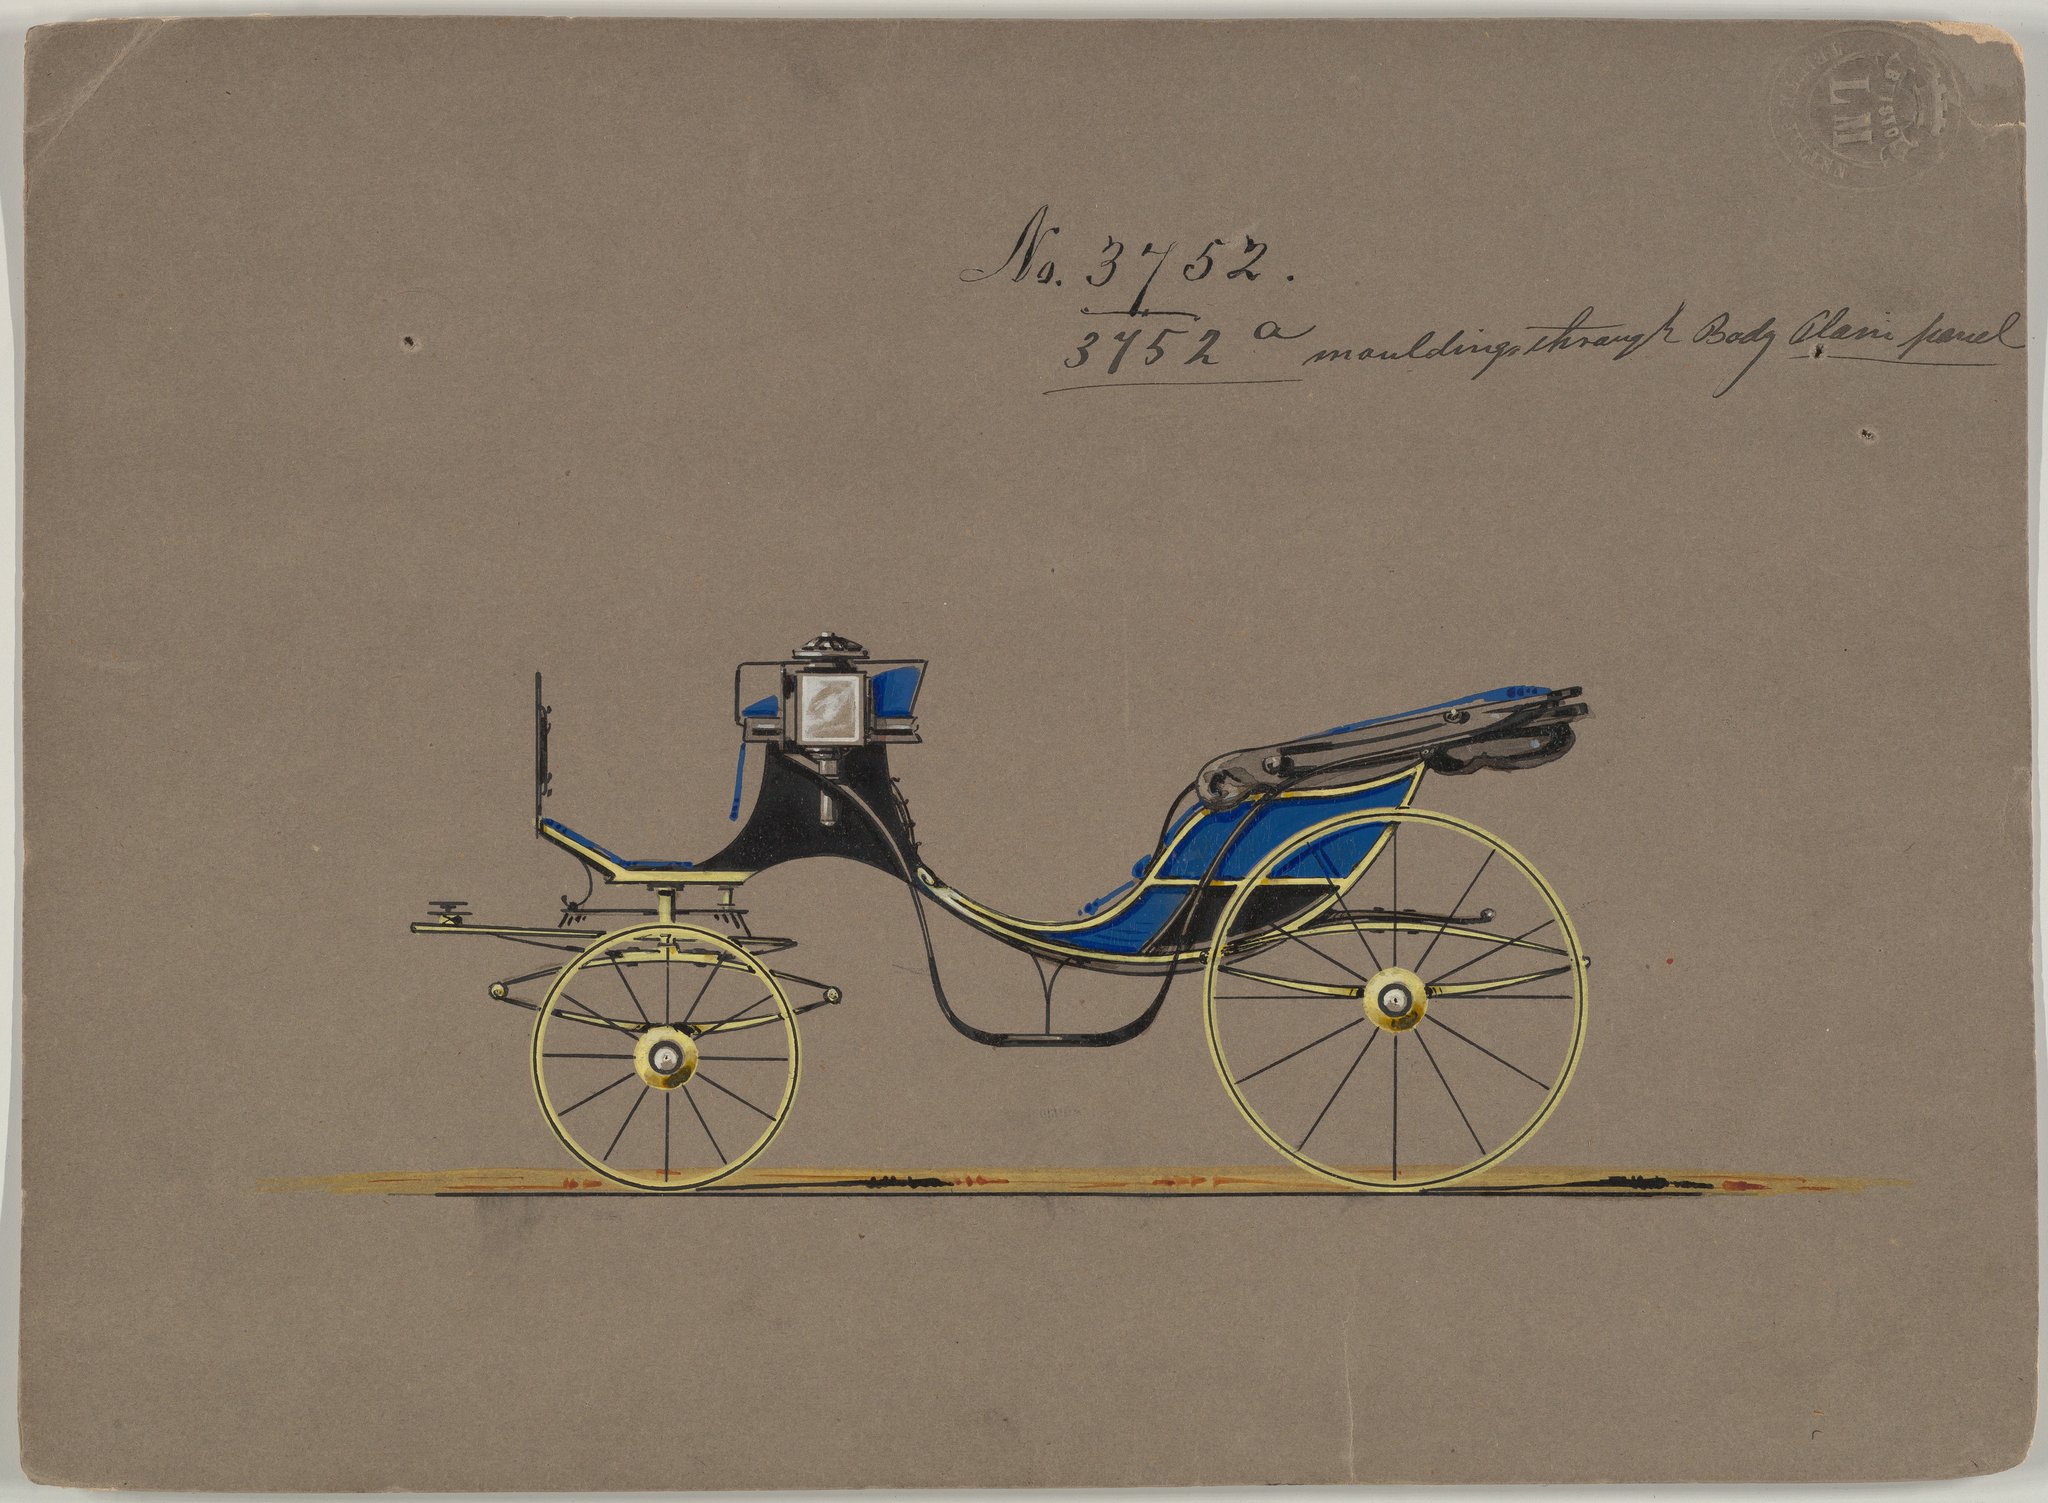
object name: drawing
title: Design for Cabriolet or Victoria, no. 3752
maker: brewster & co.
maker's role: manufacturer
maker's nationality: american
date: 1882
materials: gouache, gum arabic, ink, watercolor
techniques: pen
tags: carriages